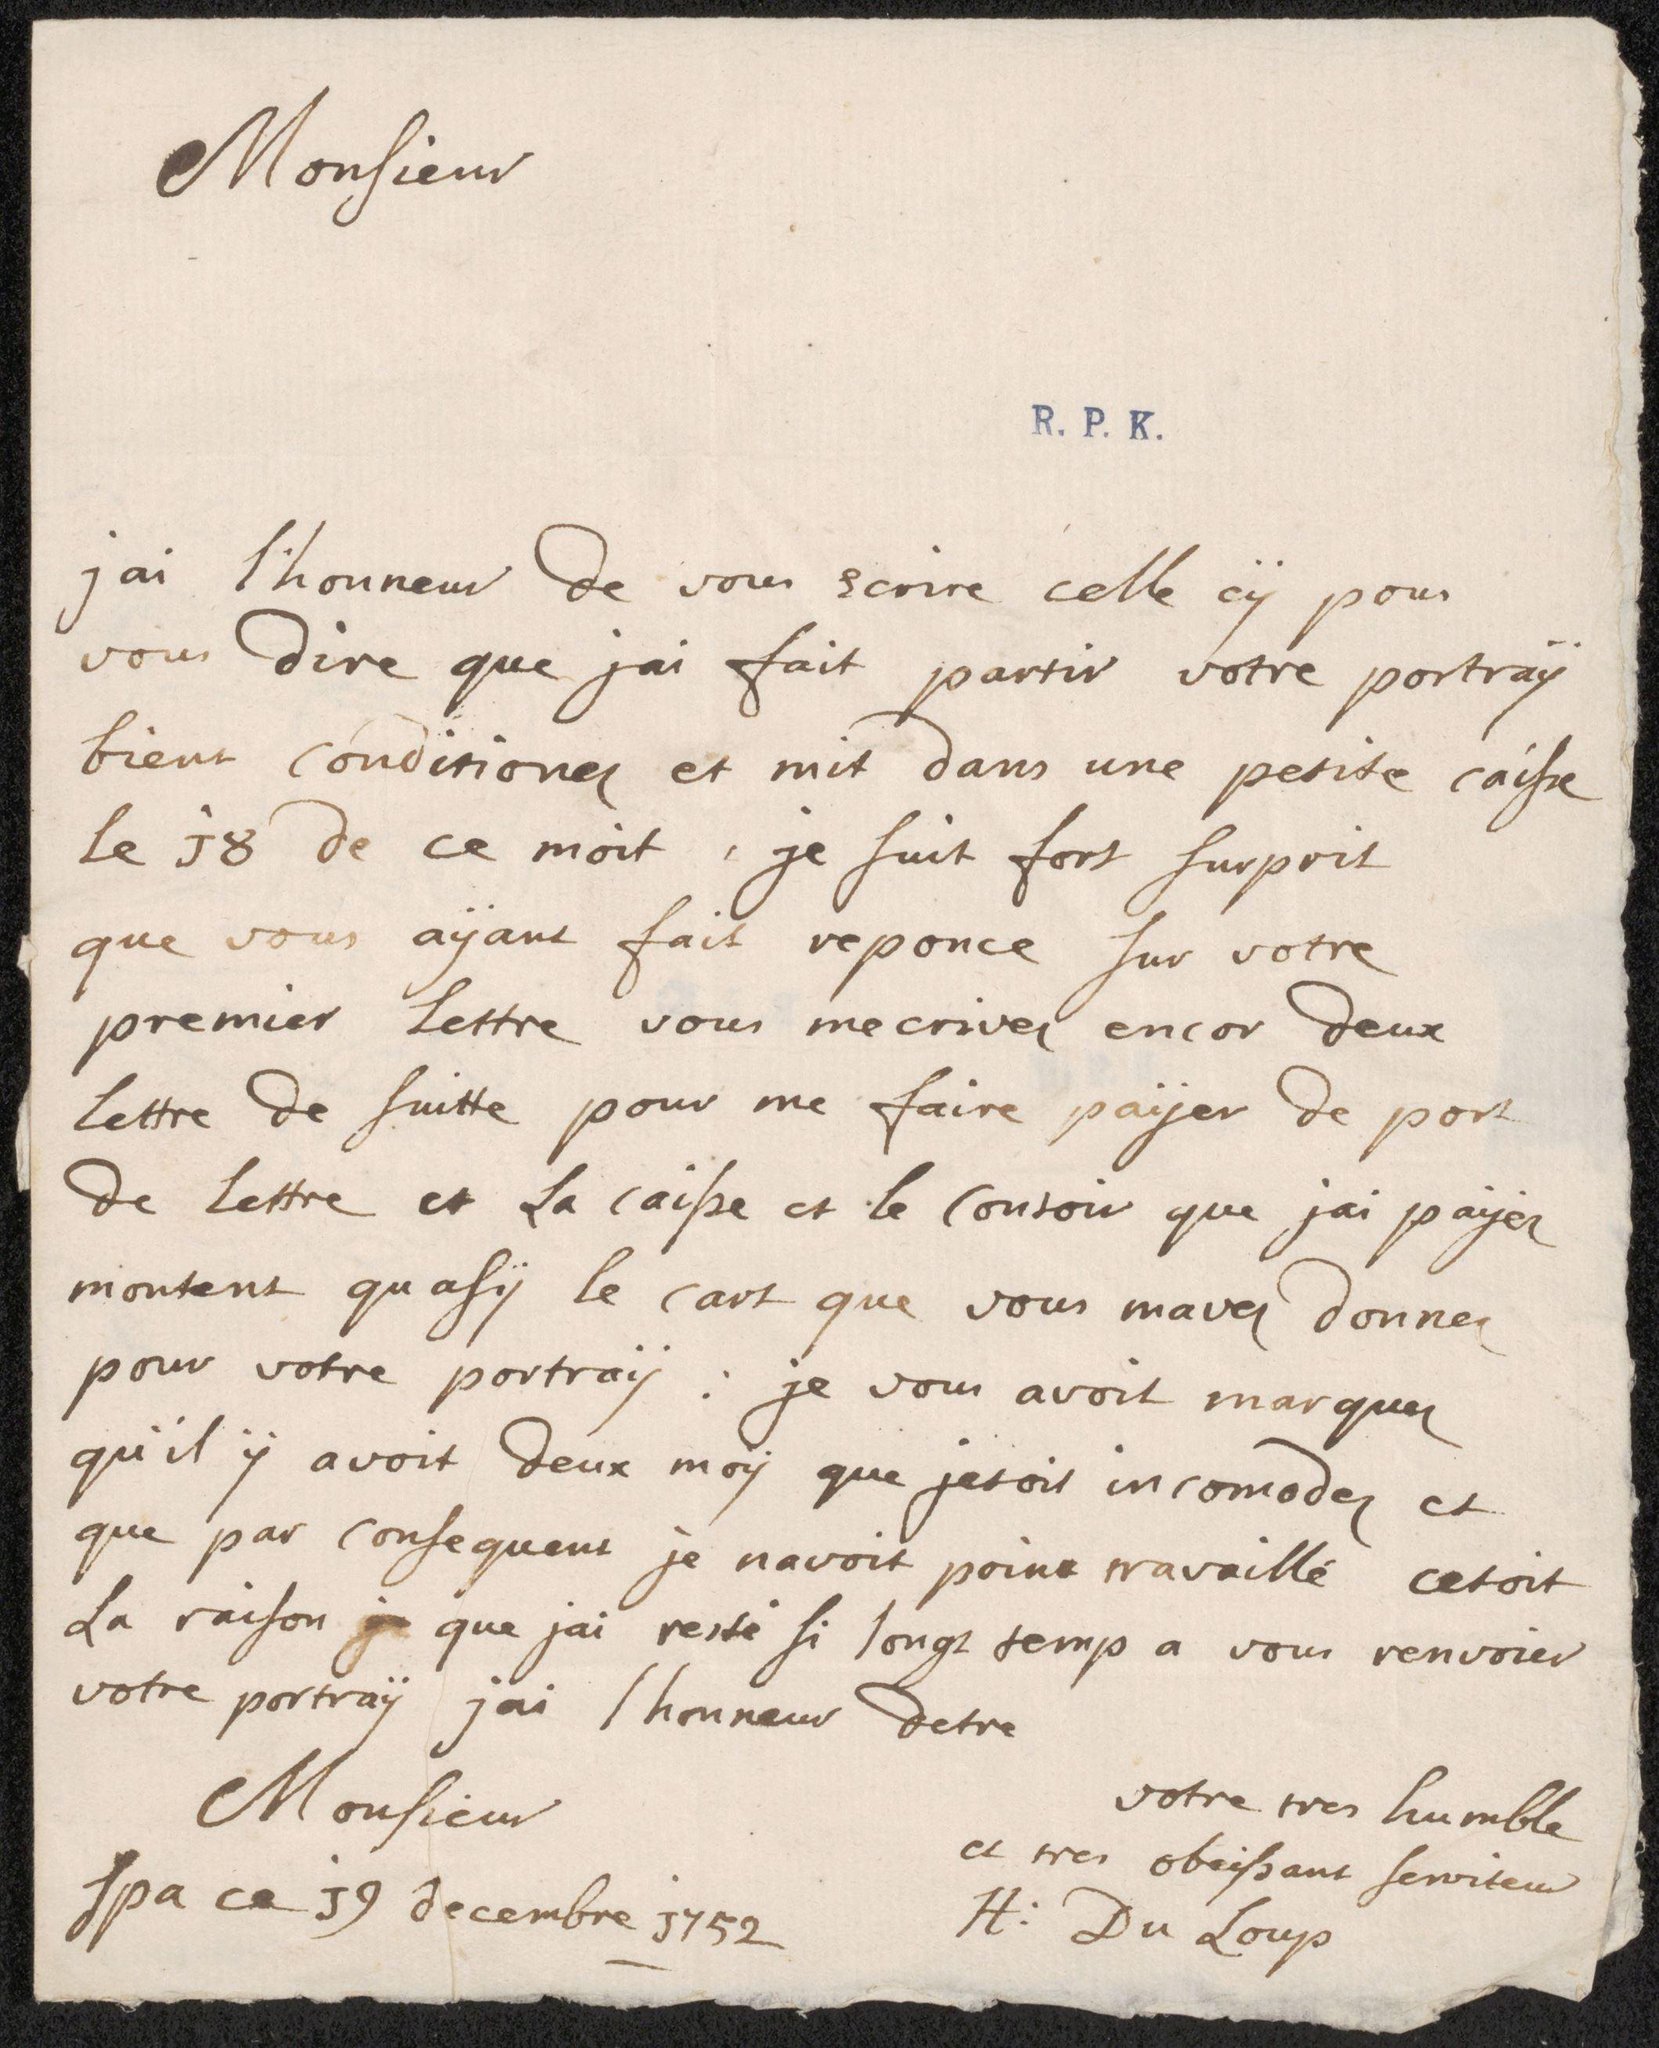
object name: letter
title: Brief aan Willem Liedel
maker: Anonymous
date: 1752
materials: ink, paper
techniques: pen, writing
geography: spa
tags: historical persons (portraits and scenes from the life)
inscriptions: seal, watermark, collector's mark: Lugt 2233